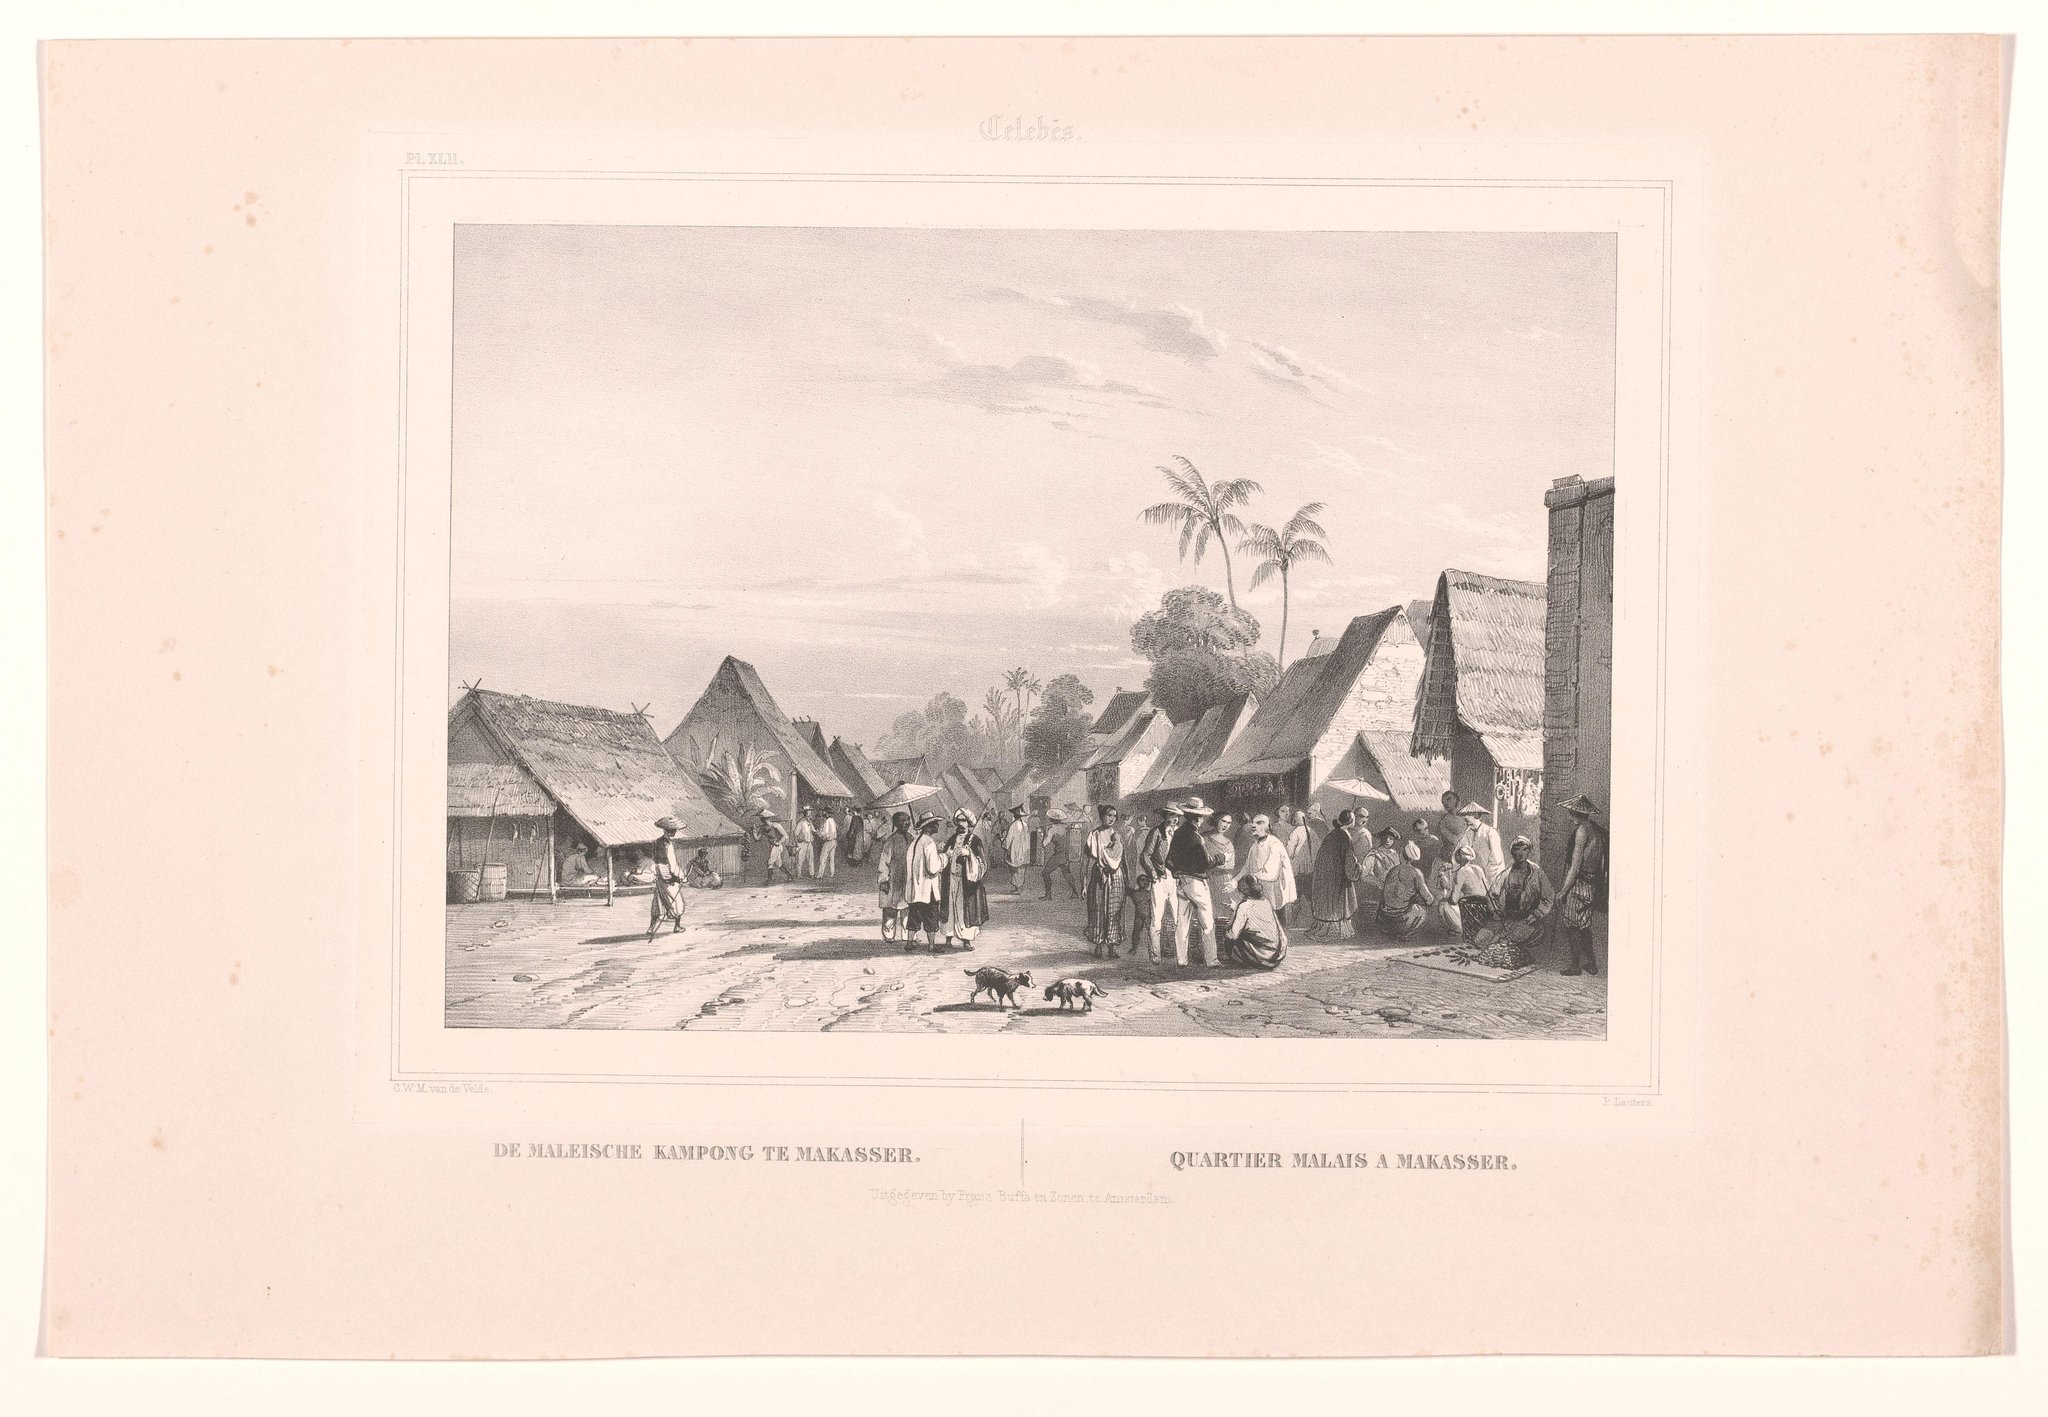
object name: print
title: Celebes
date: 1843-1845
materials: paper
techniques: lithograph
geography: amsterdam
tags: village, market, street (+ city(-scape) with figures, staffage)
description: De straat is vol met mensen. Rechts bieden verkopers hun waar aan. De straat Genummerd linksboven: Pl. XLII. De prent maakt deel uit van een omslag met drie bladen.